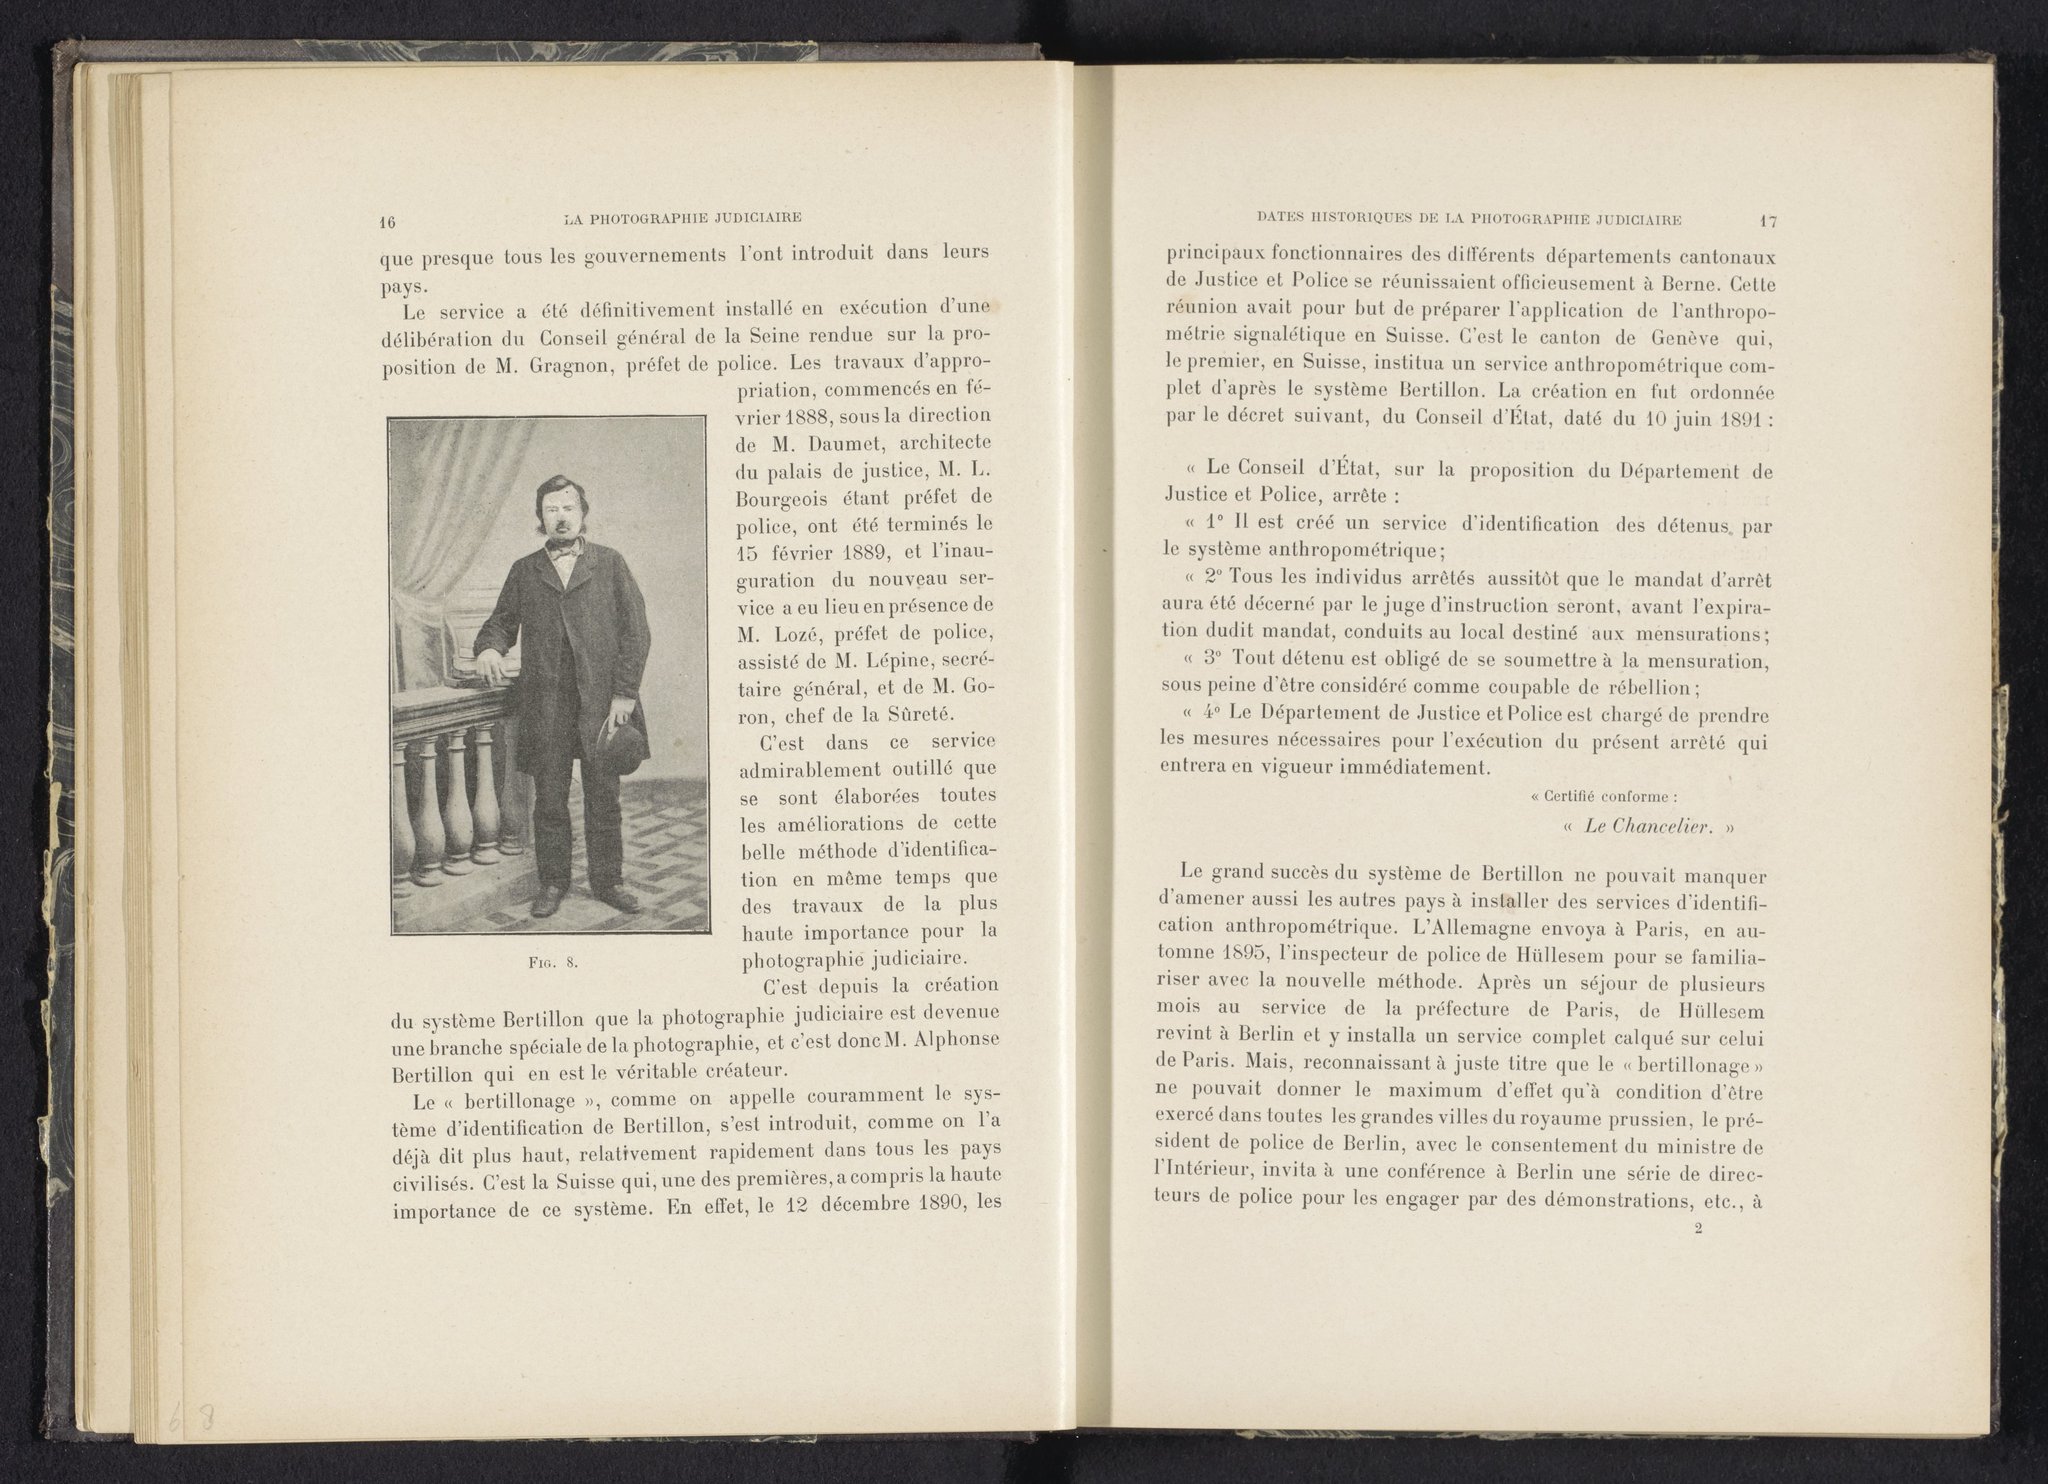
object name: photomechanical print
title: Portret van een onbekende man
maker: Anonymous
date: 1893-1903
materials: paper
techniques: autotype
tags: anonymous historical person portrayed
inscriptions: number: ‘Fig. 8.’